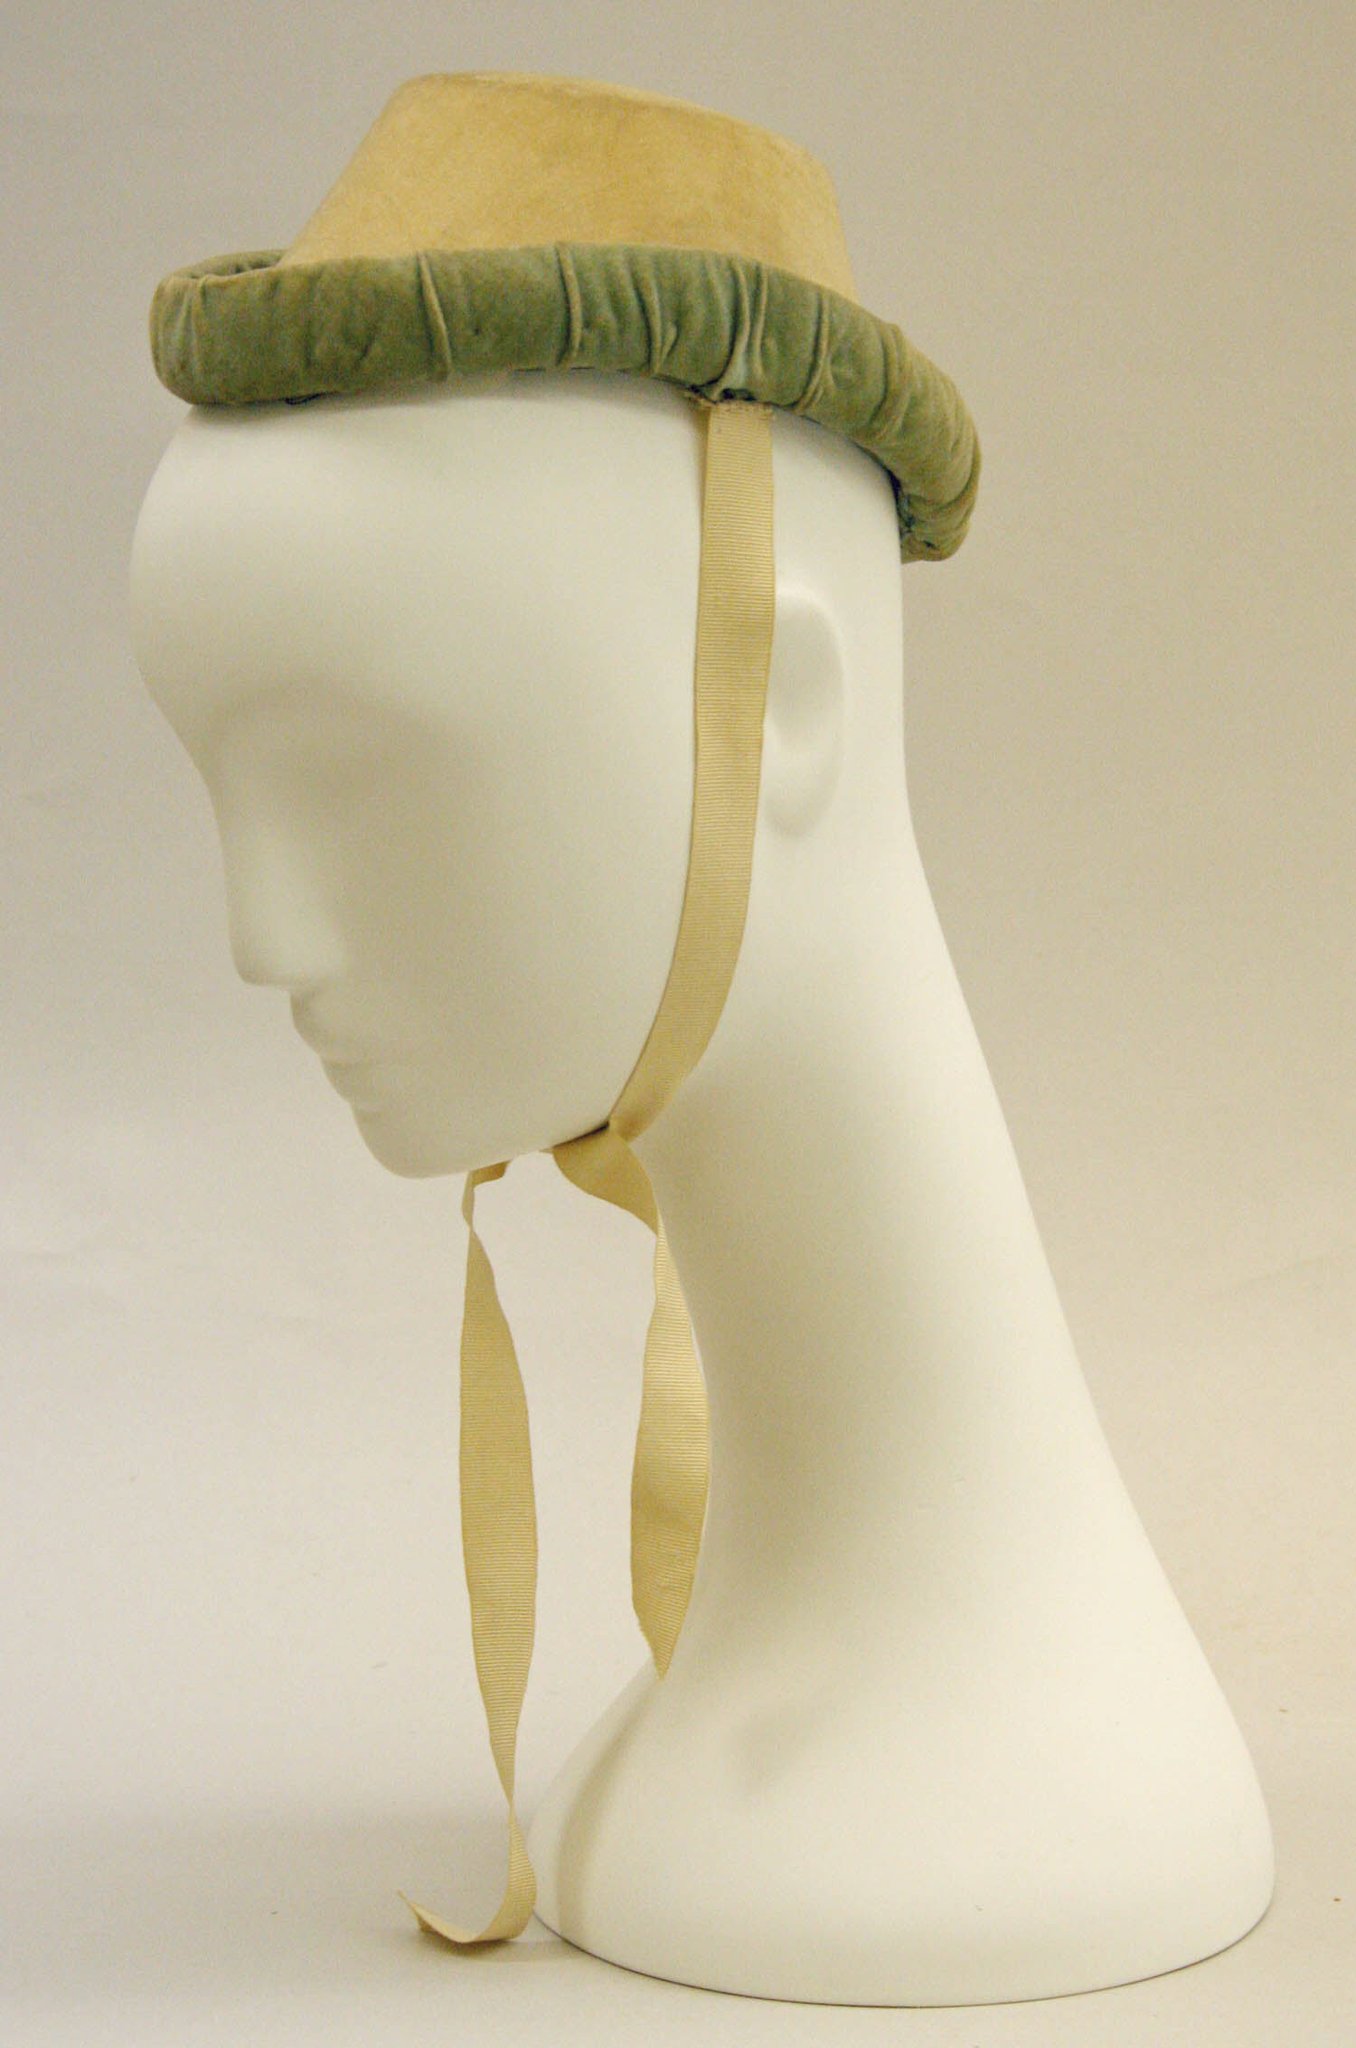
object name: hat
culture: american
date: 1870-1871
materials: silk